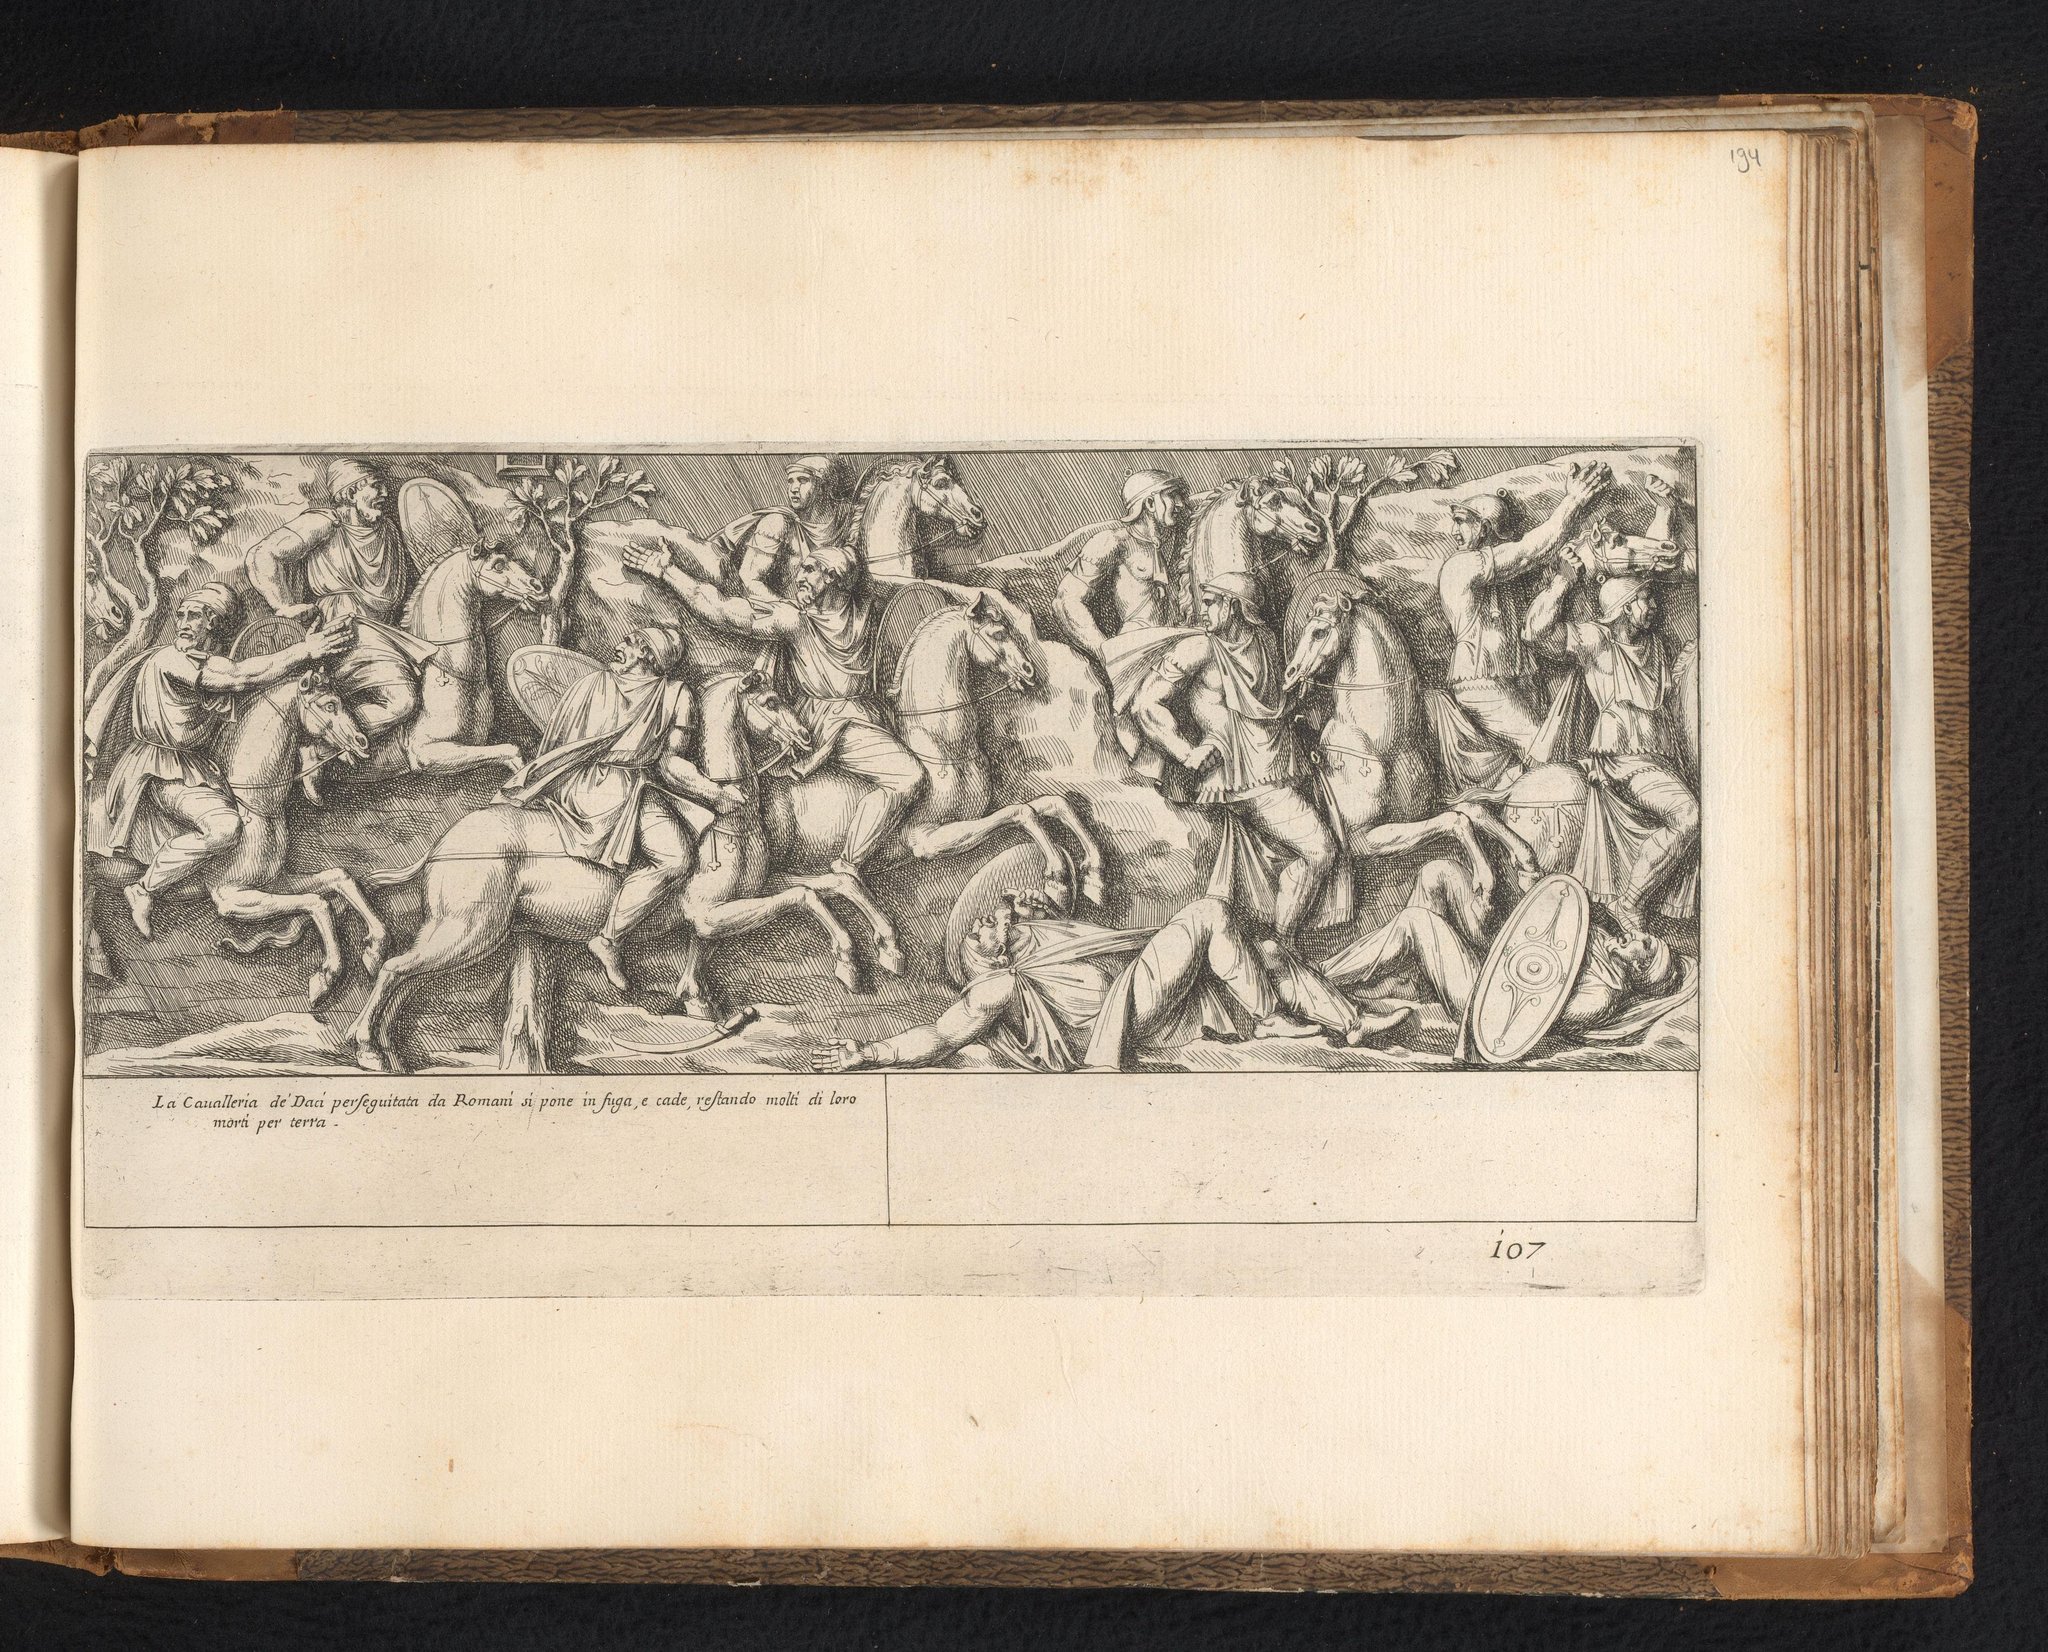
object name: print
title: Detail van het fries op de Zuil van Trajanus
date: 1637-1691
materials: paper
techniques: etching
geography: france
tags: triumphal column with helical friezes, piece of sculpture, reproduction of a piece of sculpture, the soldier; the soldier's life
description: Detail van het spiraalvormige gebeeldhouwde fries op de Zuil van Trajanus. Het fries toont de oorlogen tussen de Romeinen en de Daciërs. Verklarende nummers in de ondermarge. Prent maakt deel uit van een album.